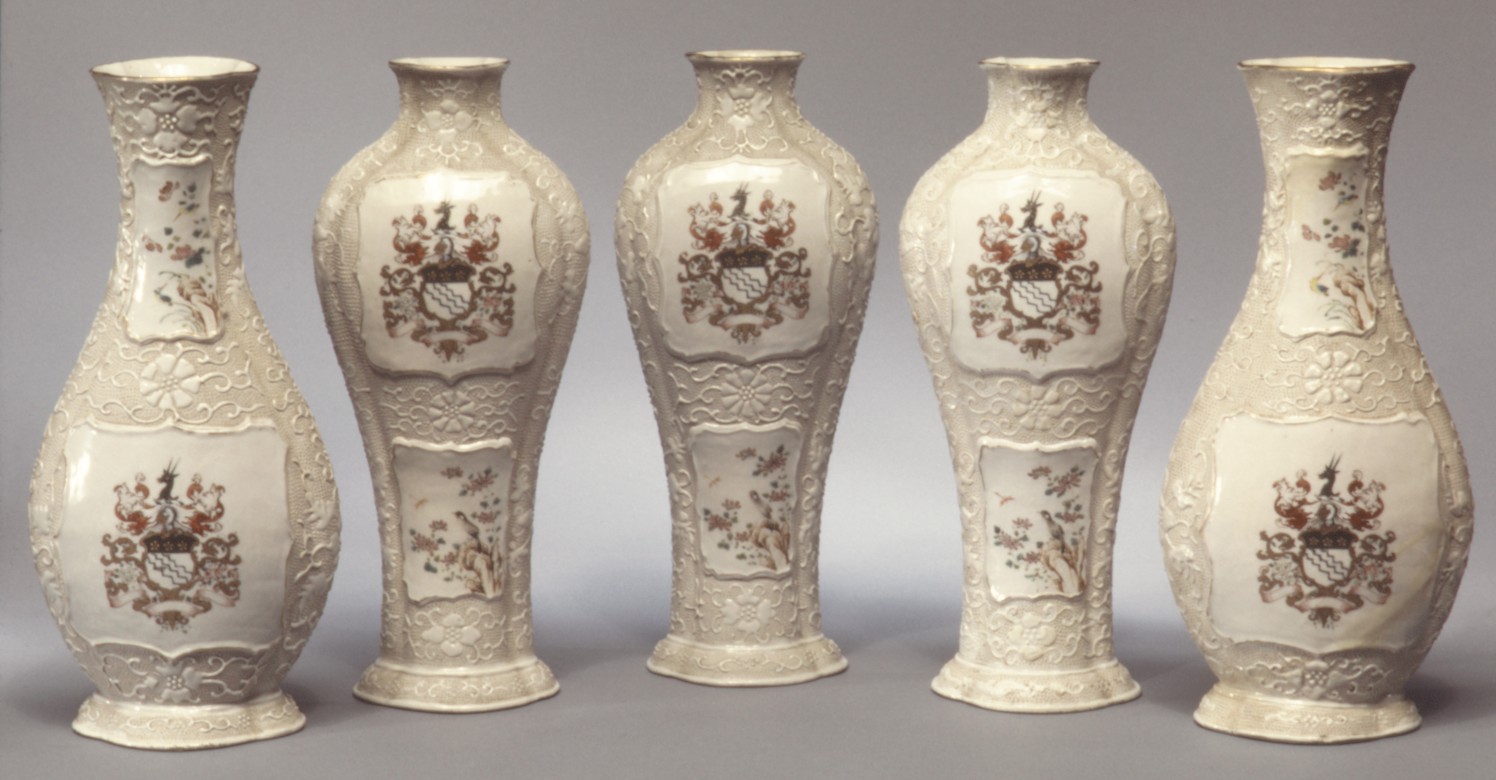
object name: vase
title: Vase (part of a garniture)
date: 1750-1760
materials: hard paste porcelain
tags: coat of arms